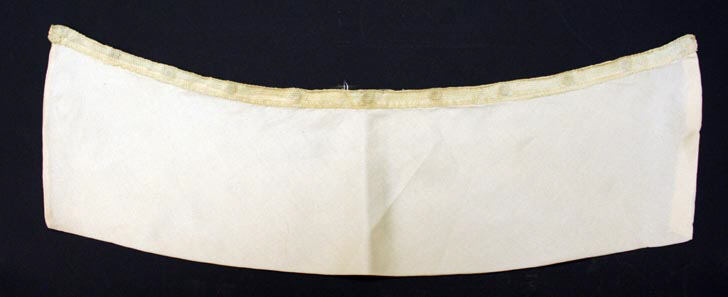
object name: collar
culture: american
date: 1700-1943